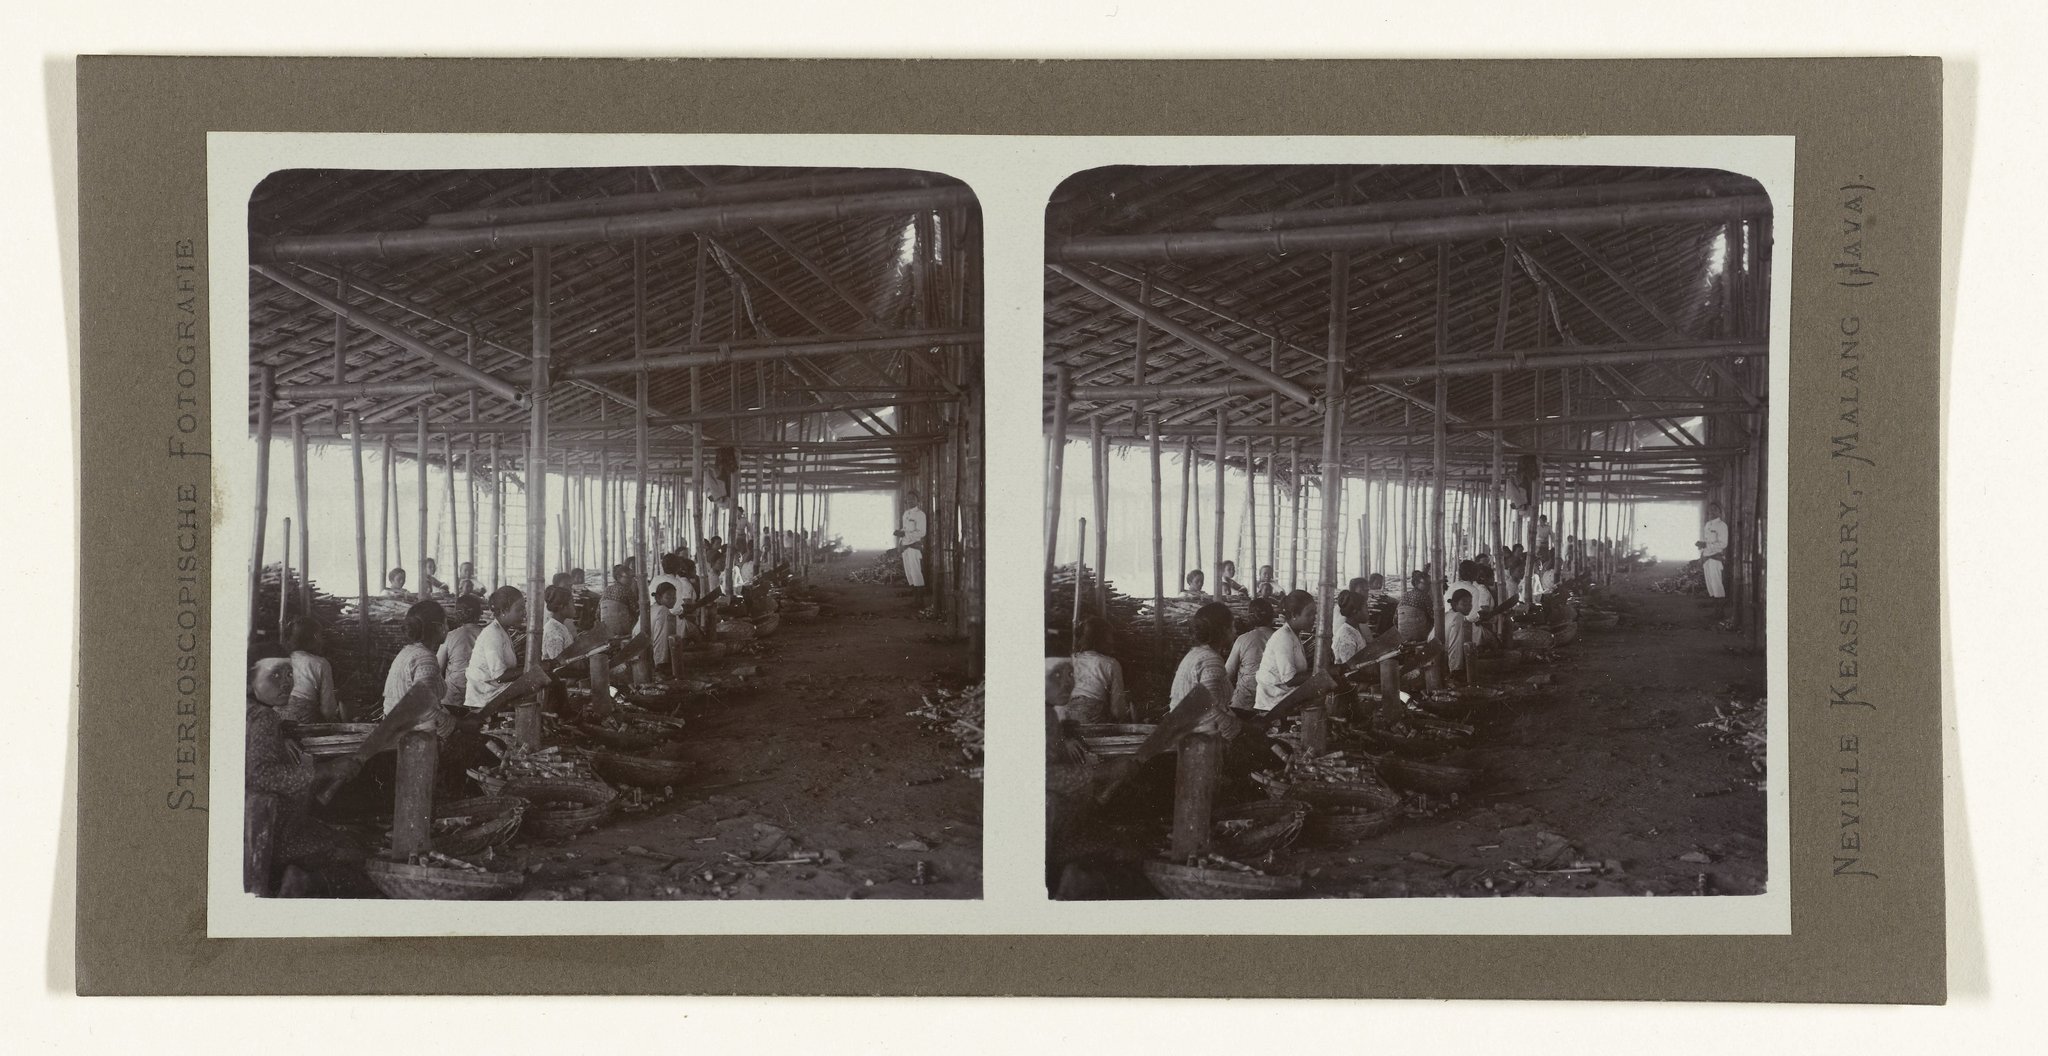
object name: stereograph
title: S 4 No 41. Suikercultuur. Het verkappen van bibit.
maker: neville keasberry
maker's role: fotograaf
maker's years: 1866-1944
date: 1900-1935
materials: cardboard, paper, photographic support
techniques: albumen print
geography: malang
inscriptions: title: ‘S 4 No 41. Suikercultuur. Het verkappen van bibit.’, inscription: ‘Stereoscopische Fotografie’, signature: ‘Neville Keasberry, Malang (Java)’